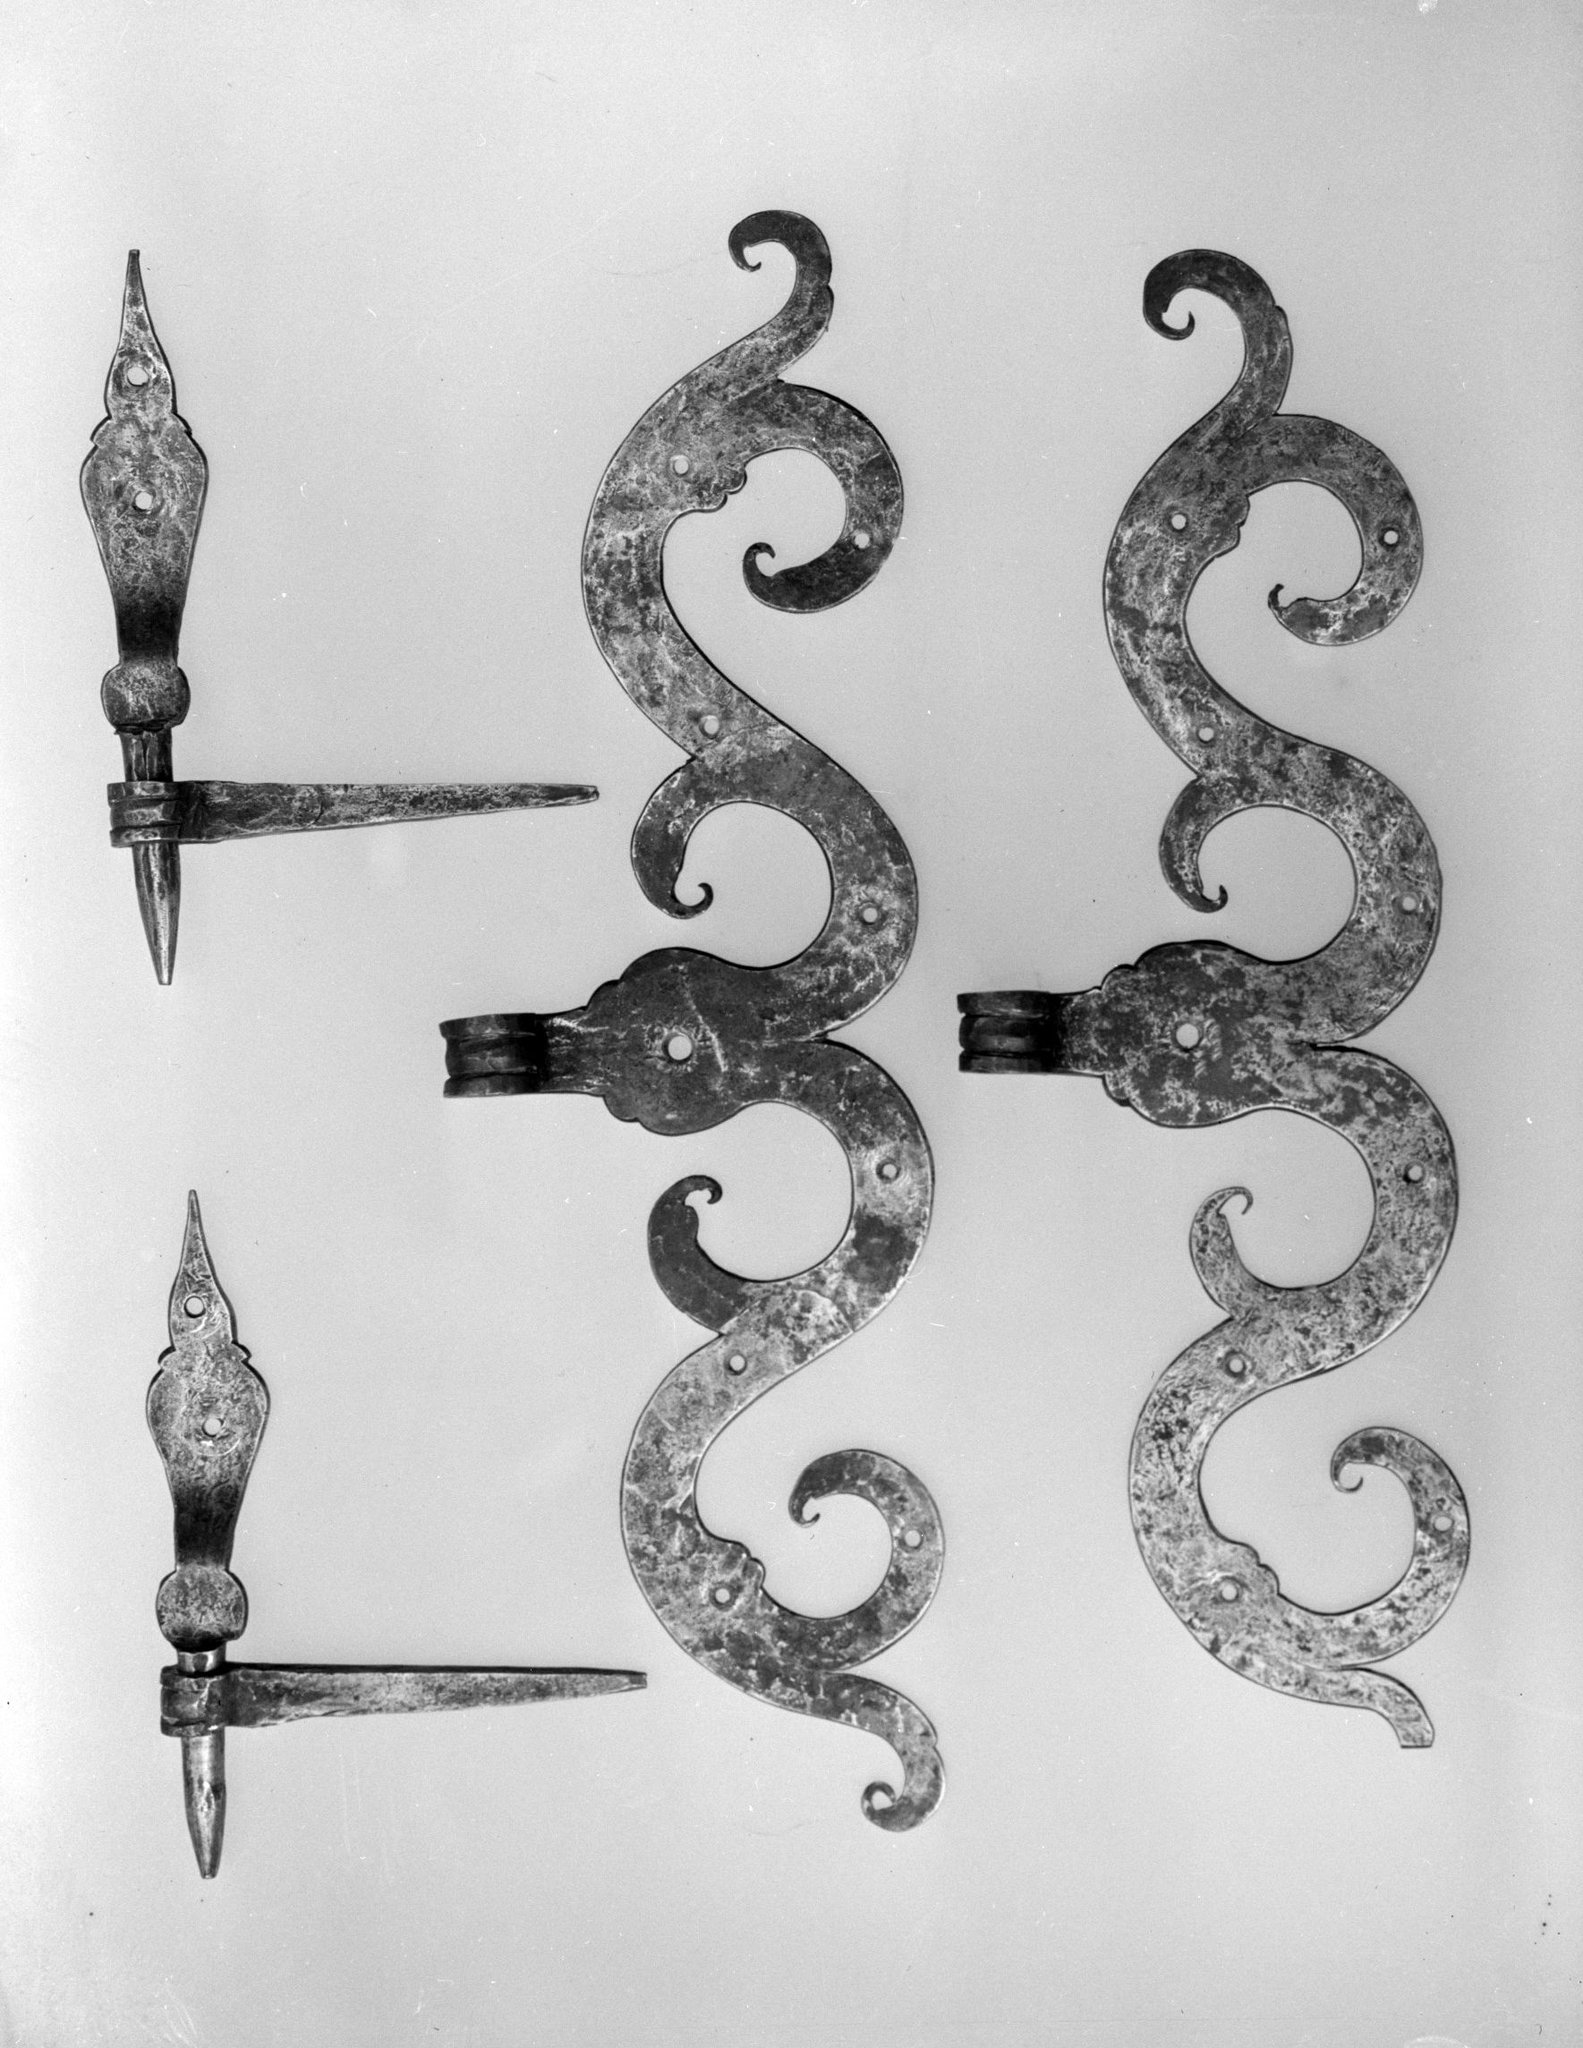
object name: hinge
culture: american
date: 1700-1800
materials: iron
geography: united states